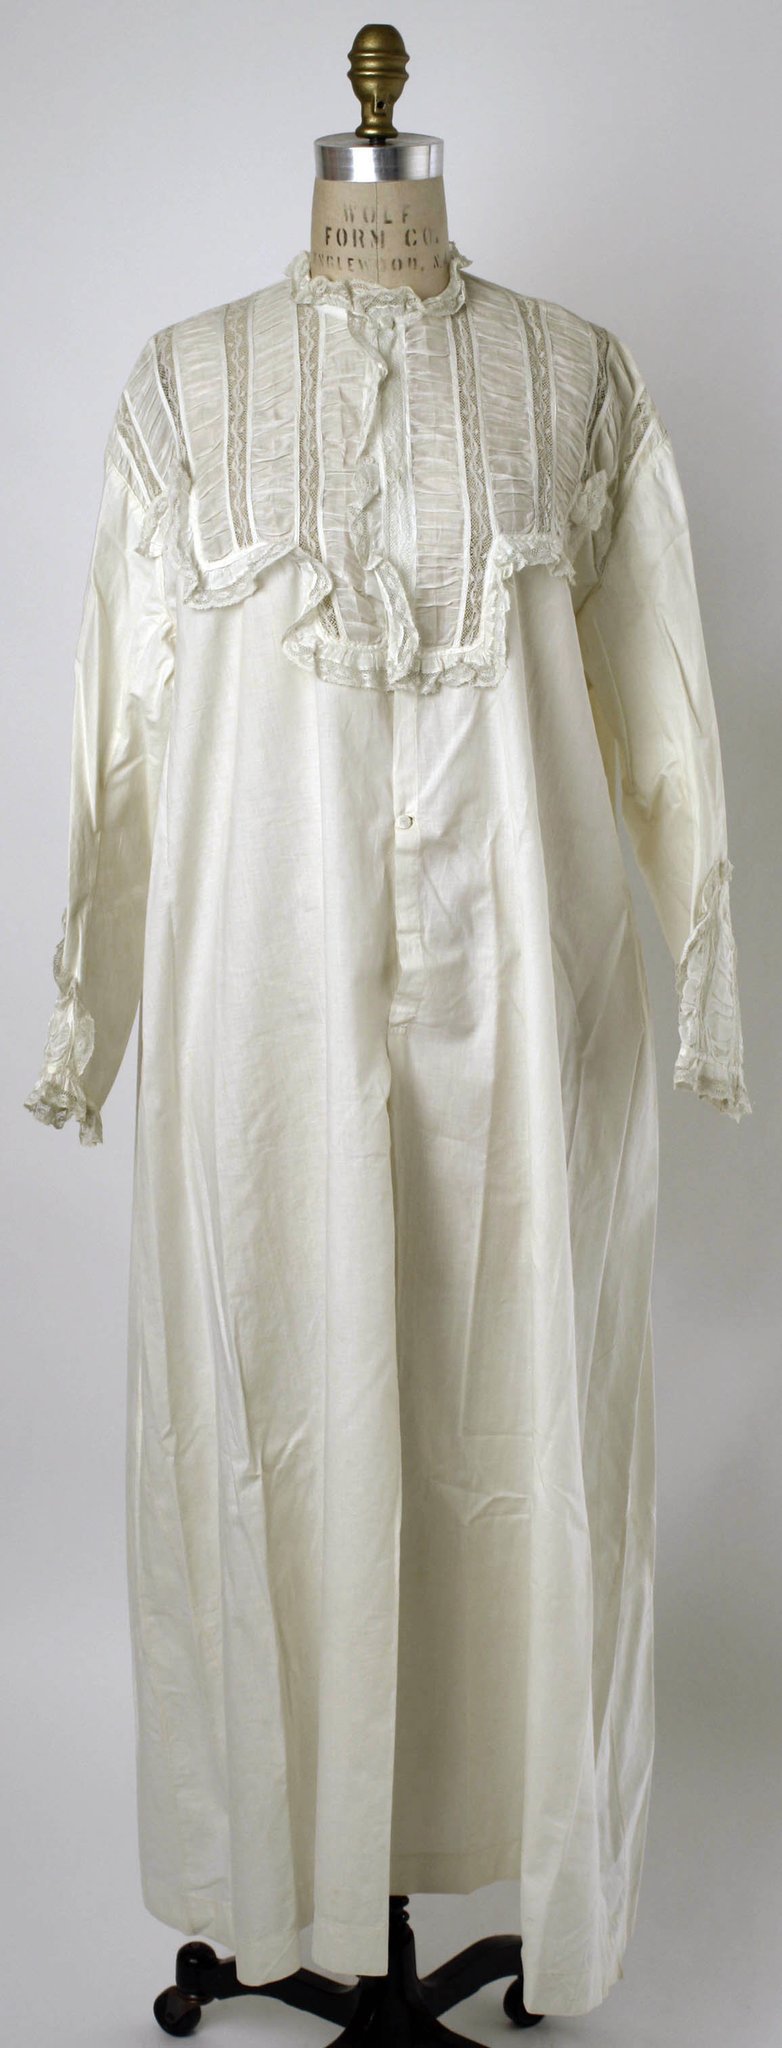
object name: lingerie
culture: american or european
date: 1871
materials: linen